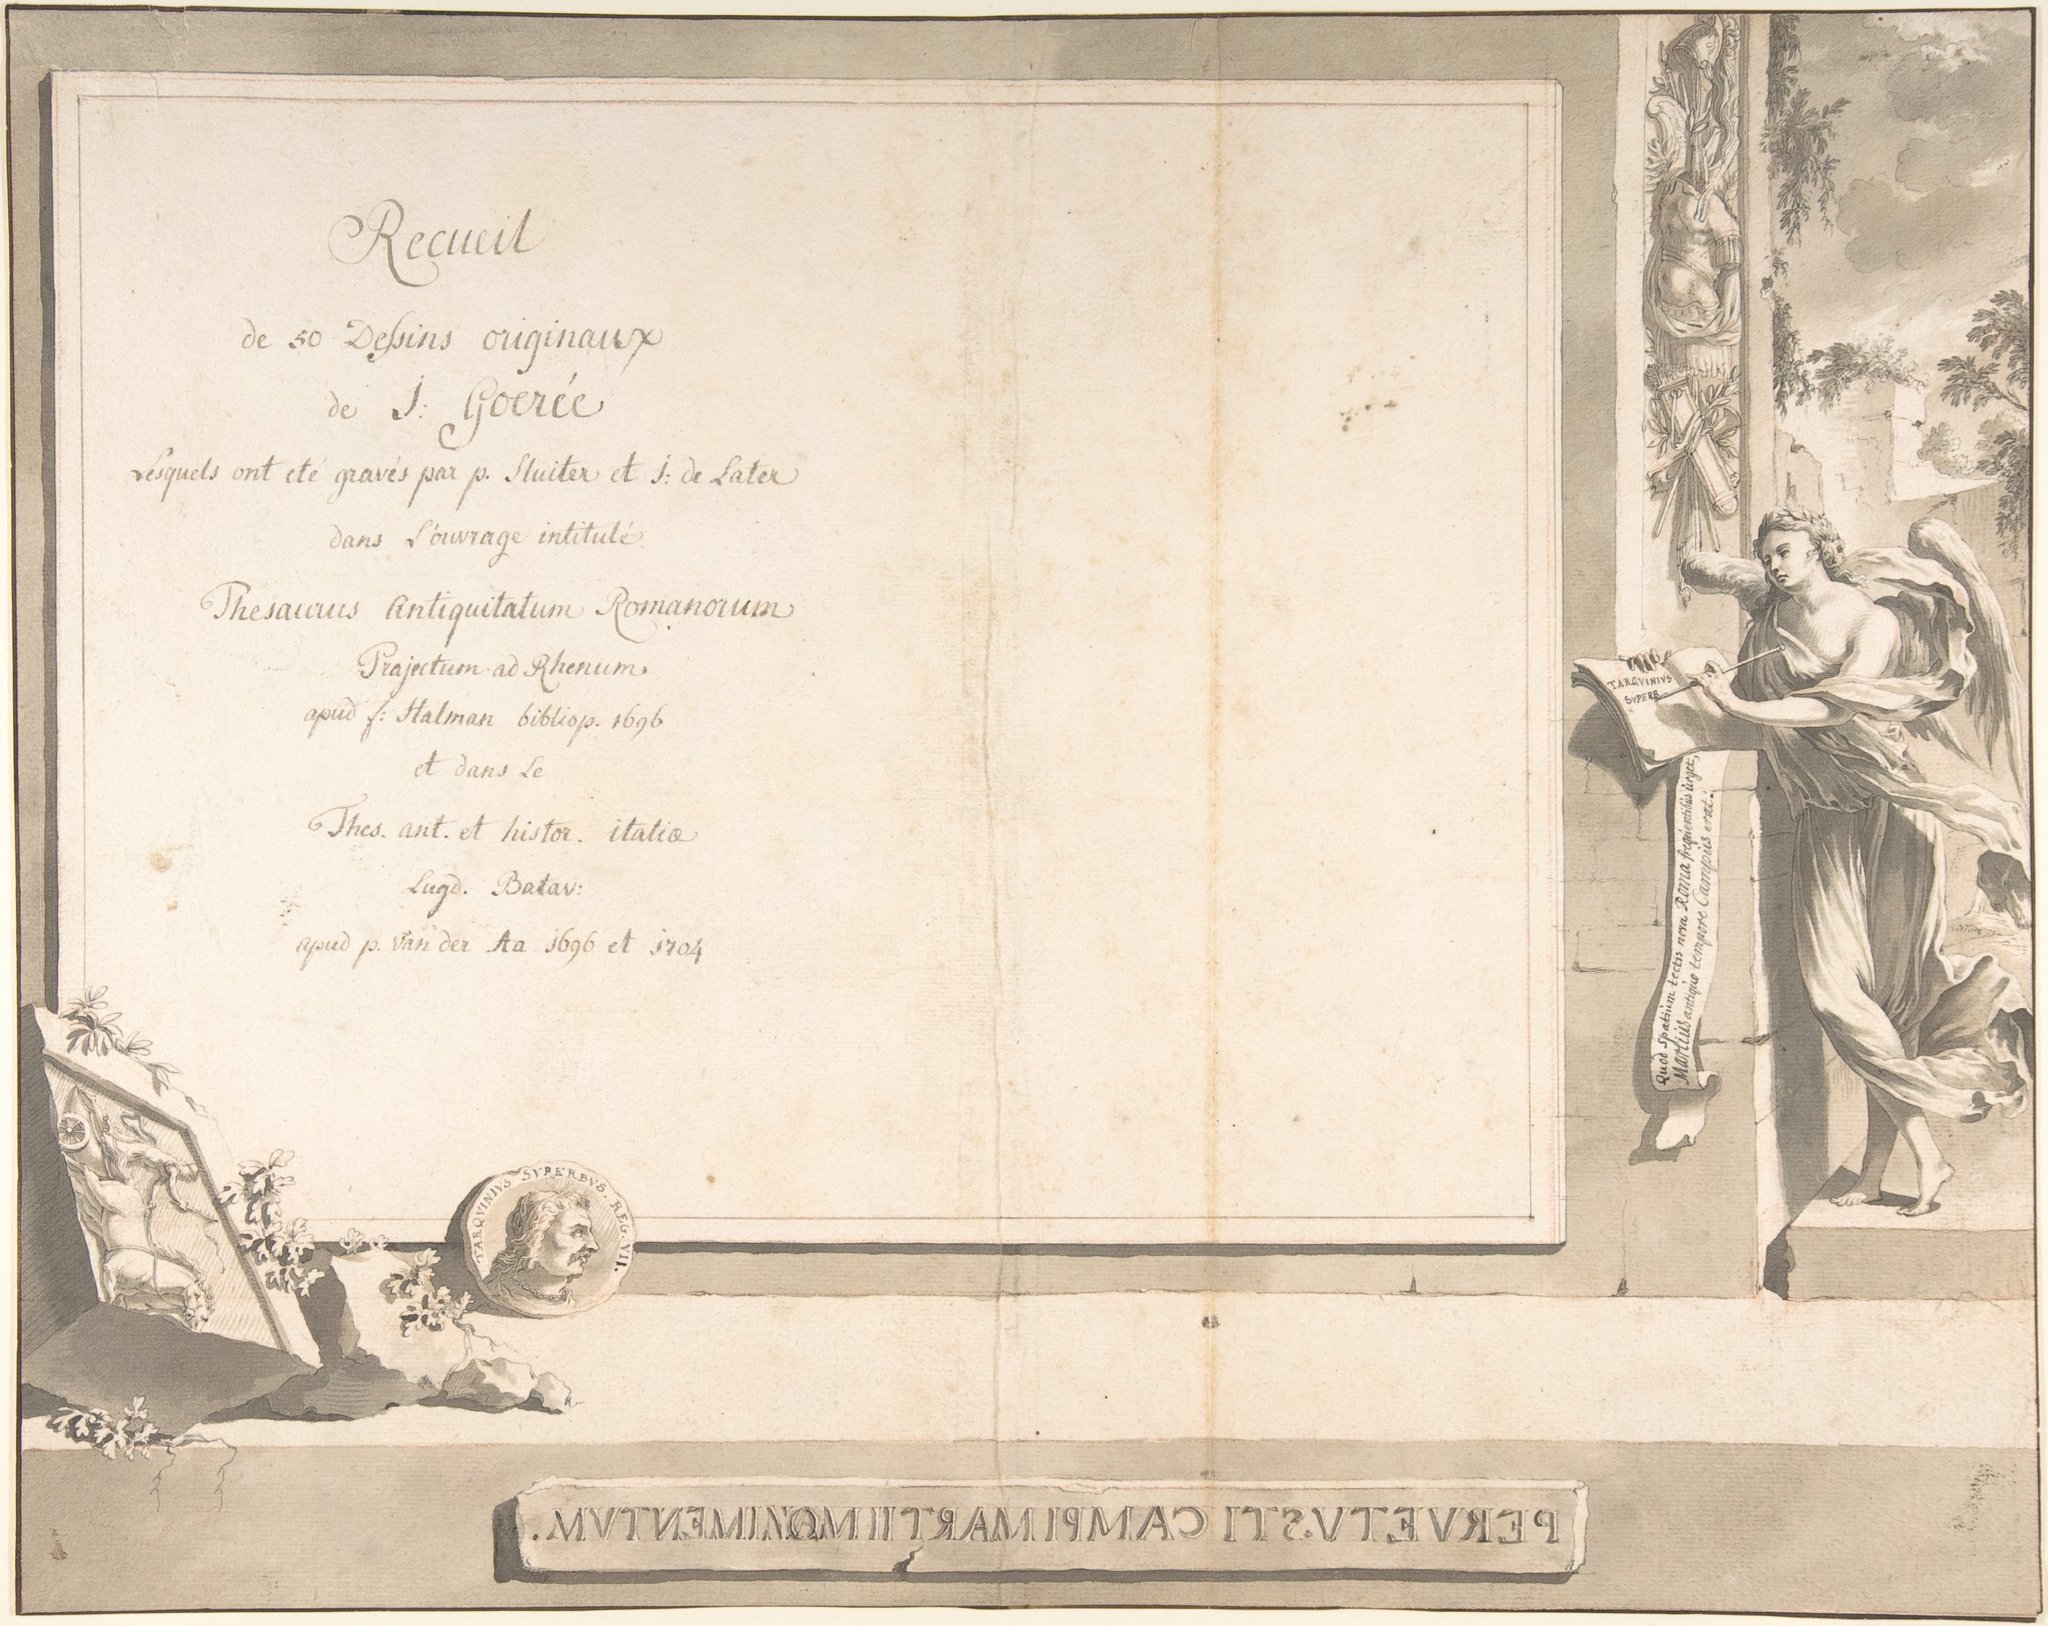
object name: drawing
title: Frontispiece for "Thesaurus Antiquitatum Romanarum"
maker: jan goeree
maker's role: artist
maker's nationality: dutch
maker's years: 1670-1731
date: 1704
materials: chalk, ink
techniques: brush, pen, wash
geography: italy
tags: writing